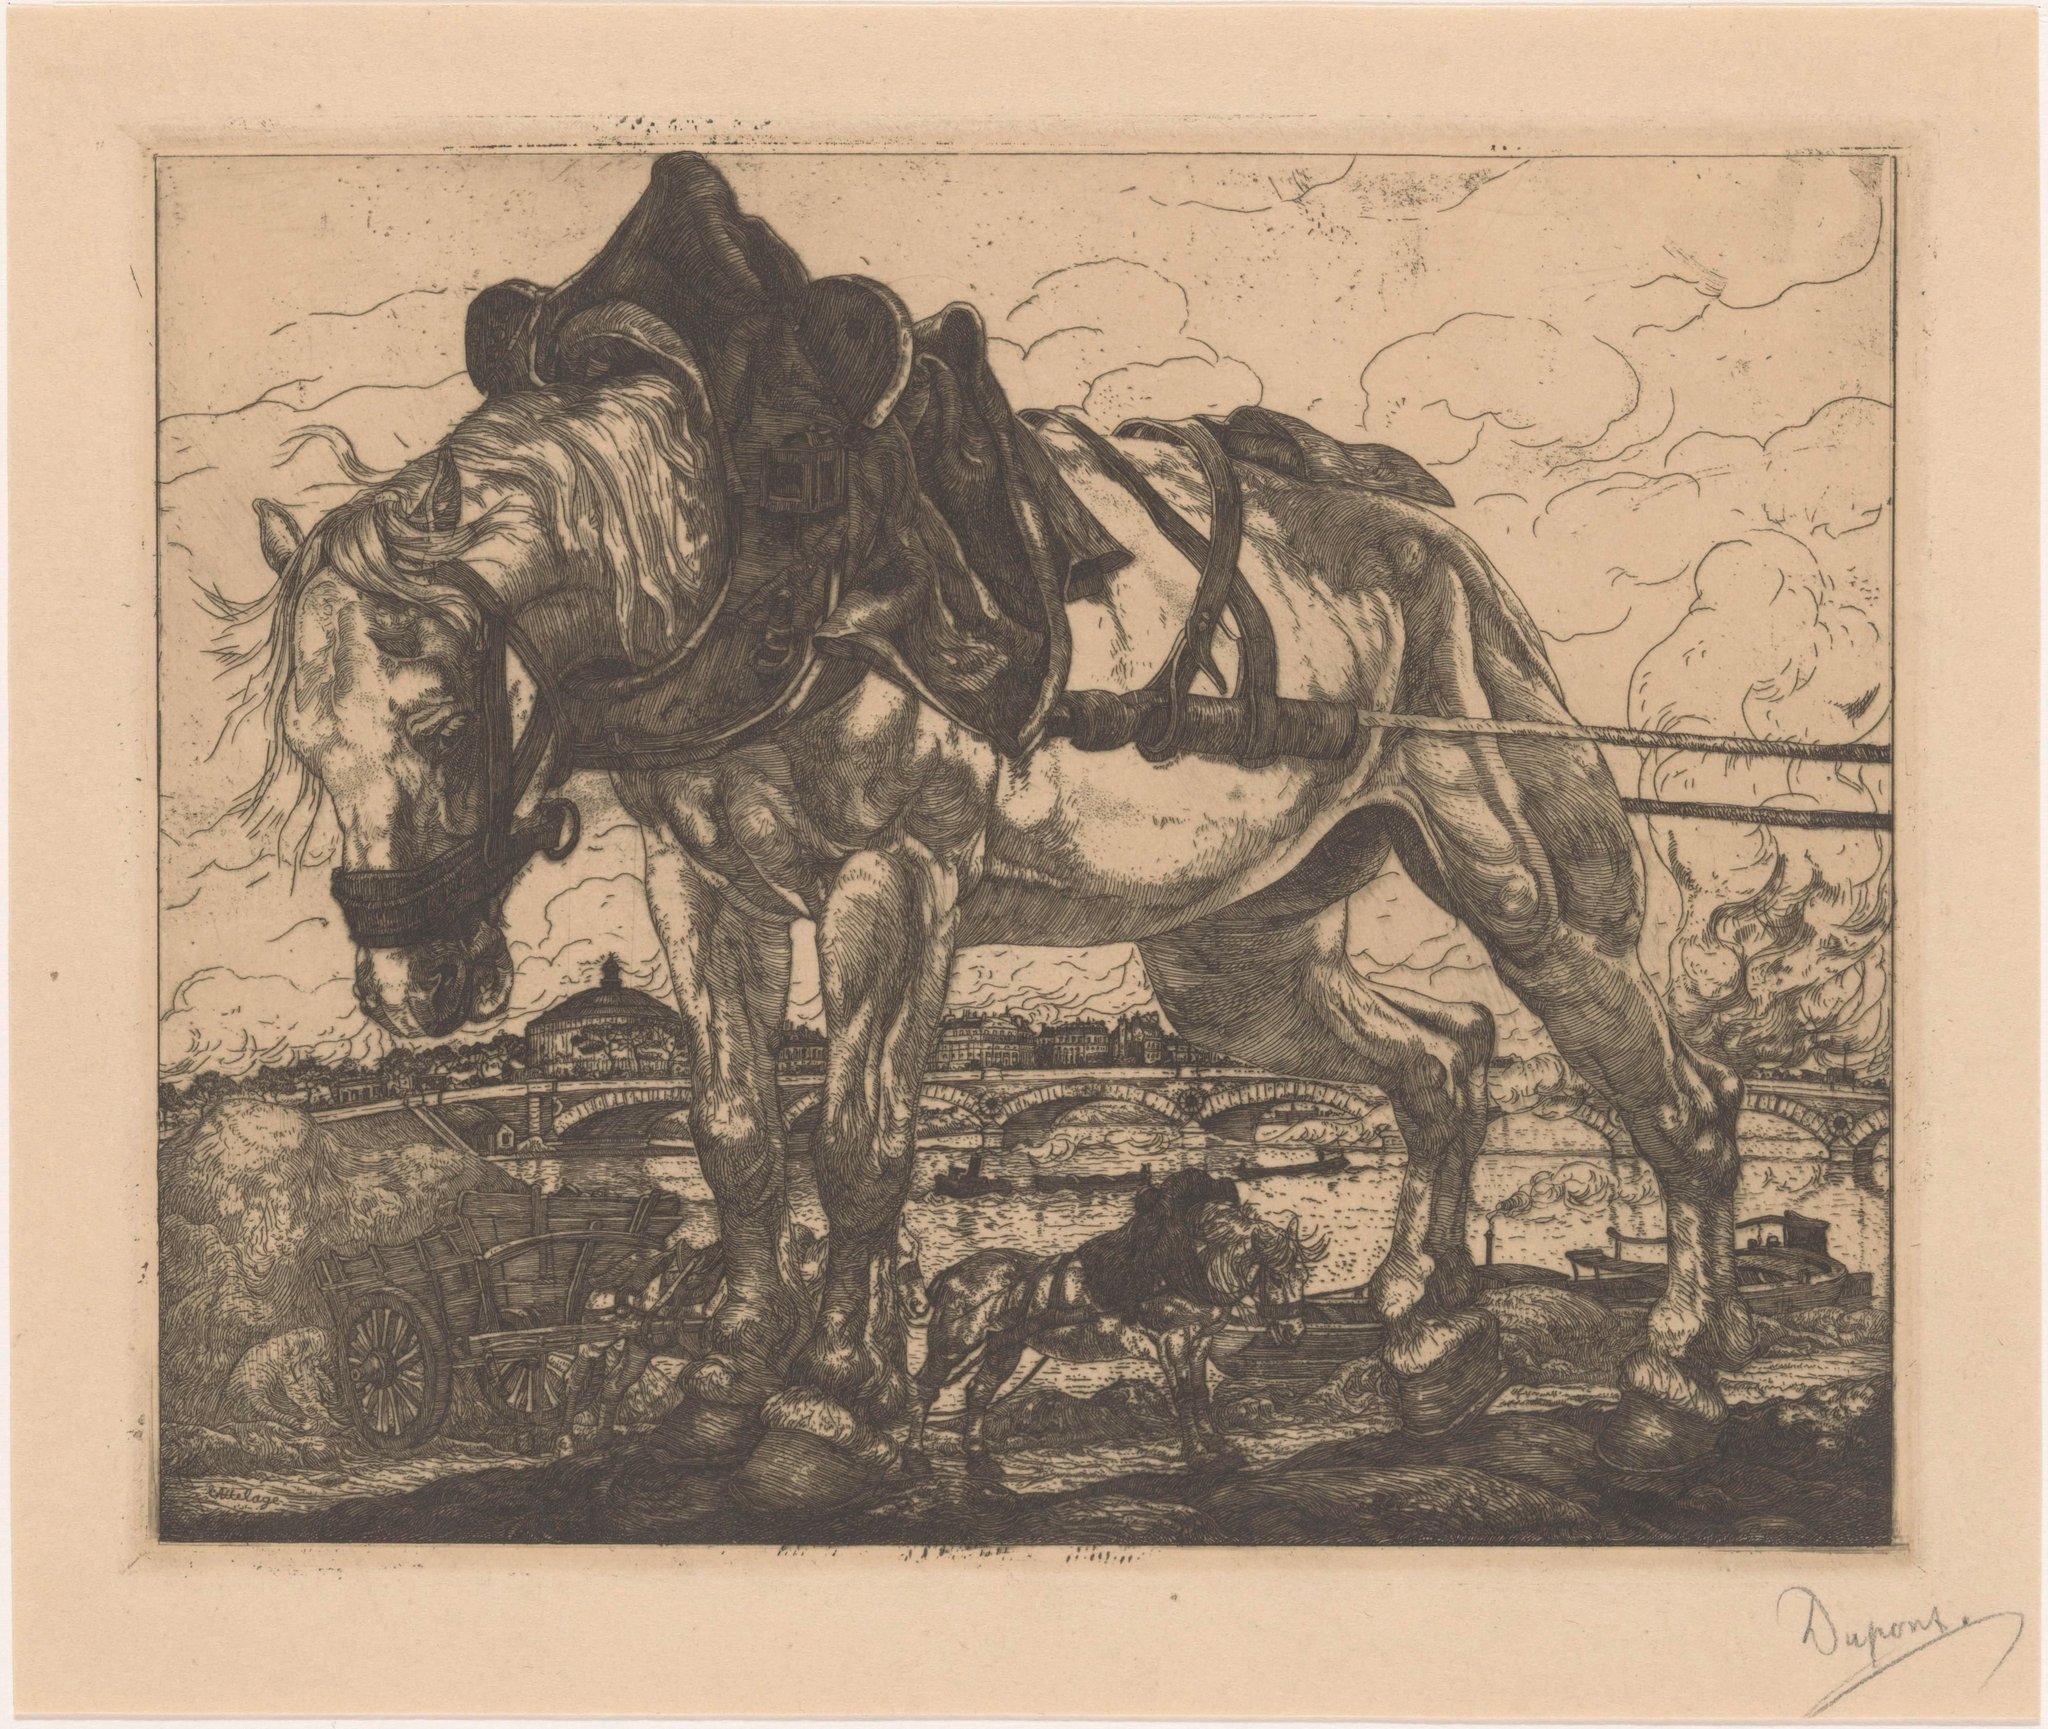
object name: print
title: L'Attelage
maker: pieter dupont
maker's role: draughtsman, print maker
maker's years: 1870-1911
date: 1898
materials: paper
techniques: etching, intaglio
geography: paris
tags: city-view, and landscape with man-made constructions, horse, paris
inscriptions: collector's mark: Lugt 2233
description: Achter het paard een vierspan. Op de achtergrond de Seine, met links mogelijk het Grand Palais.